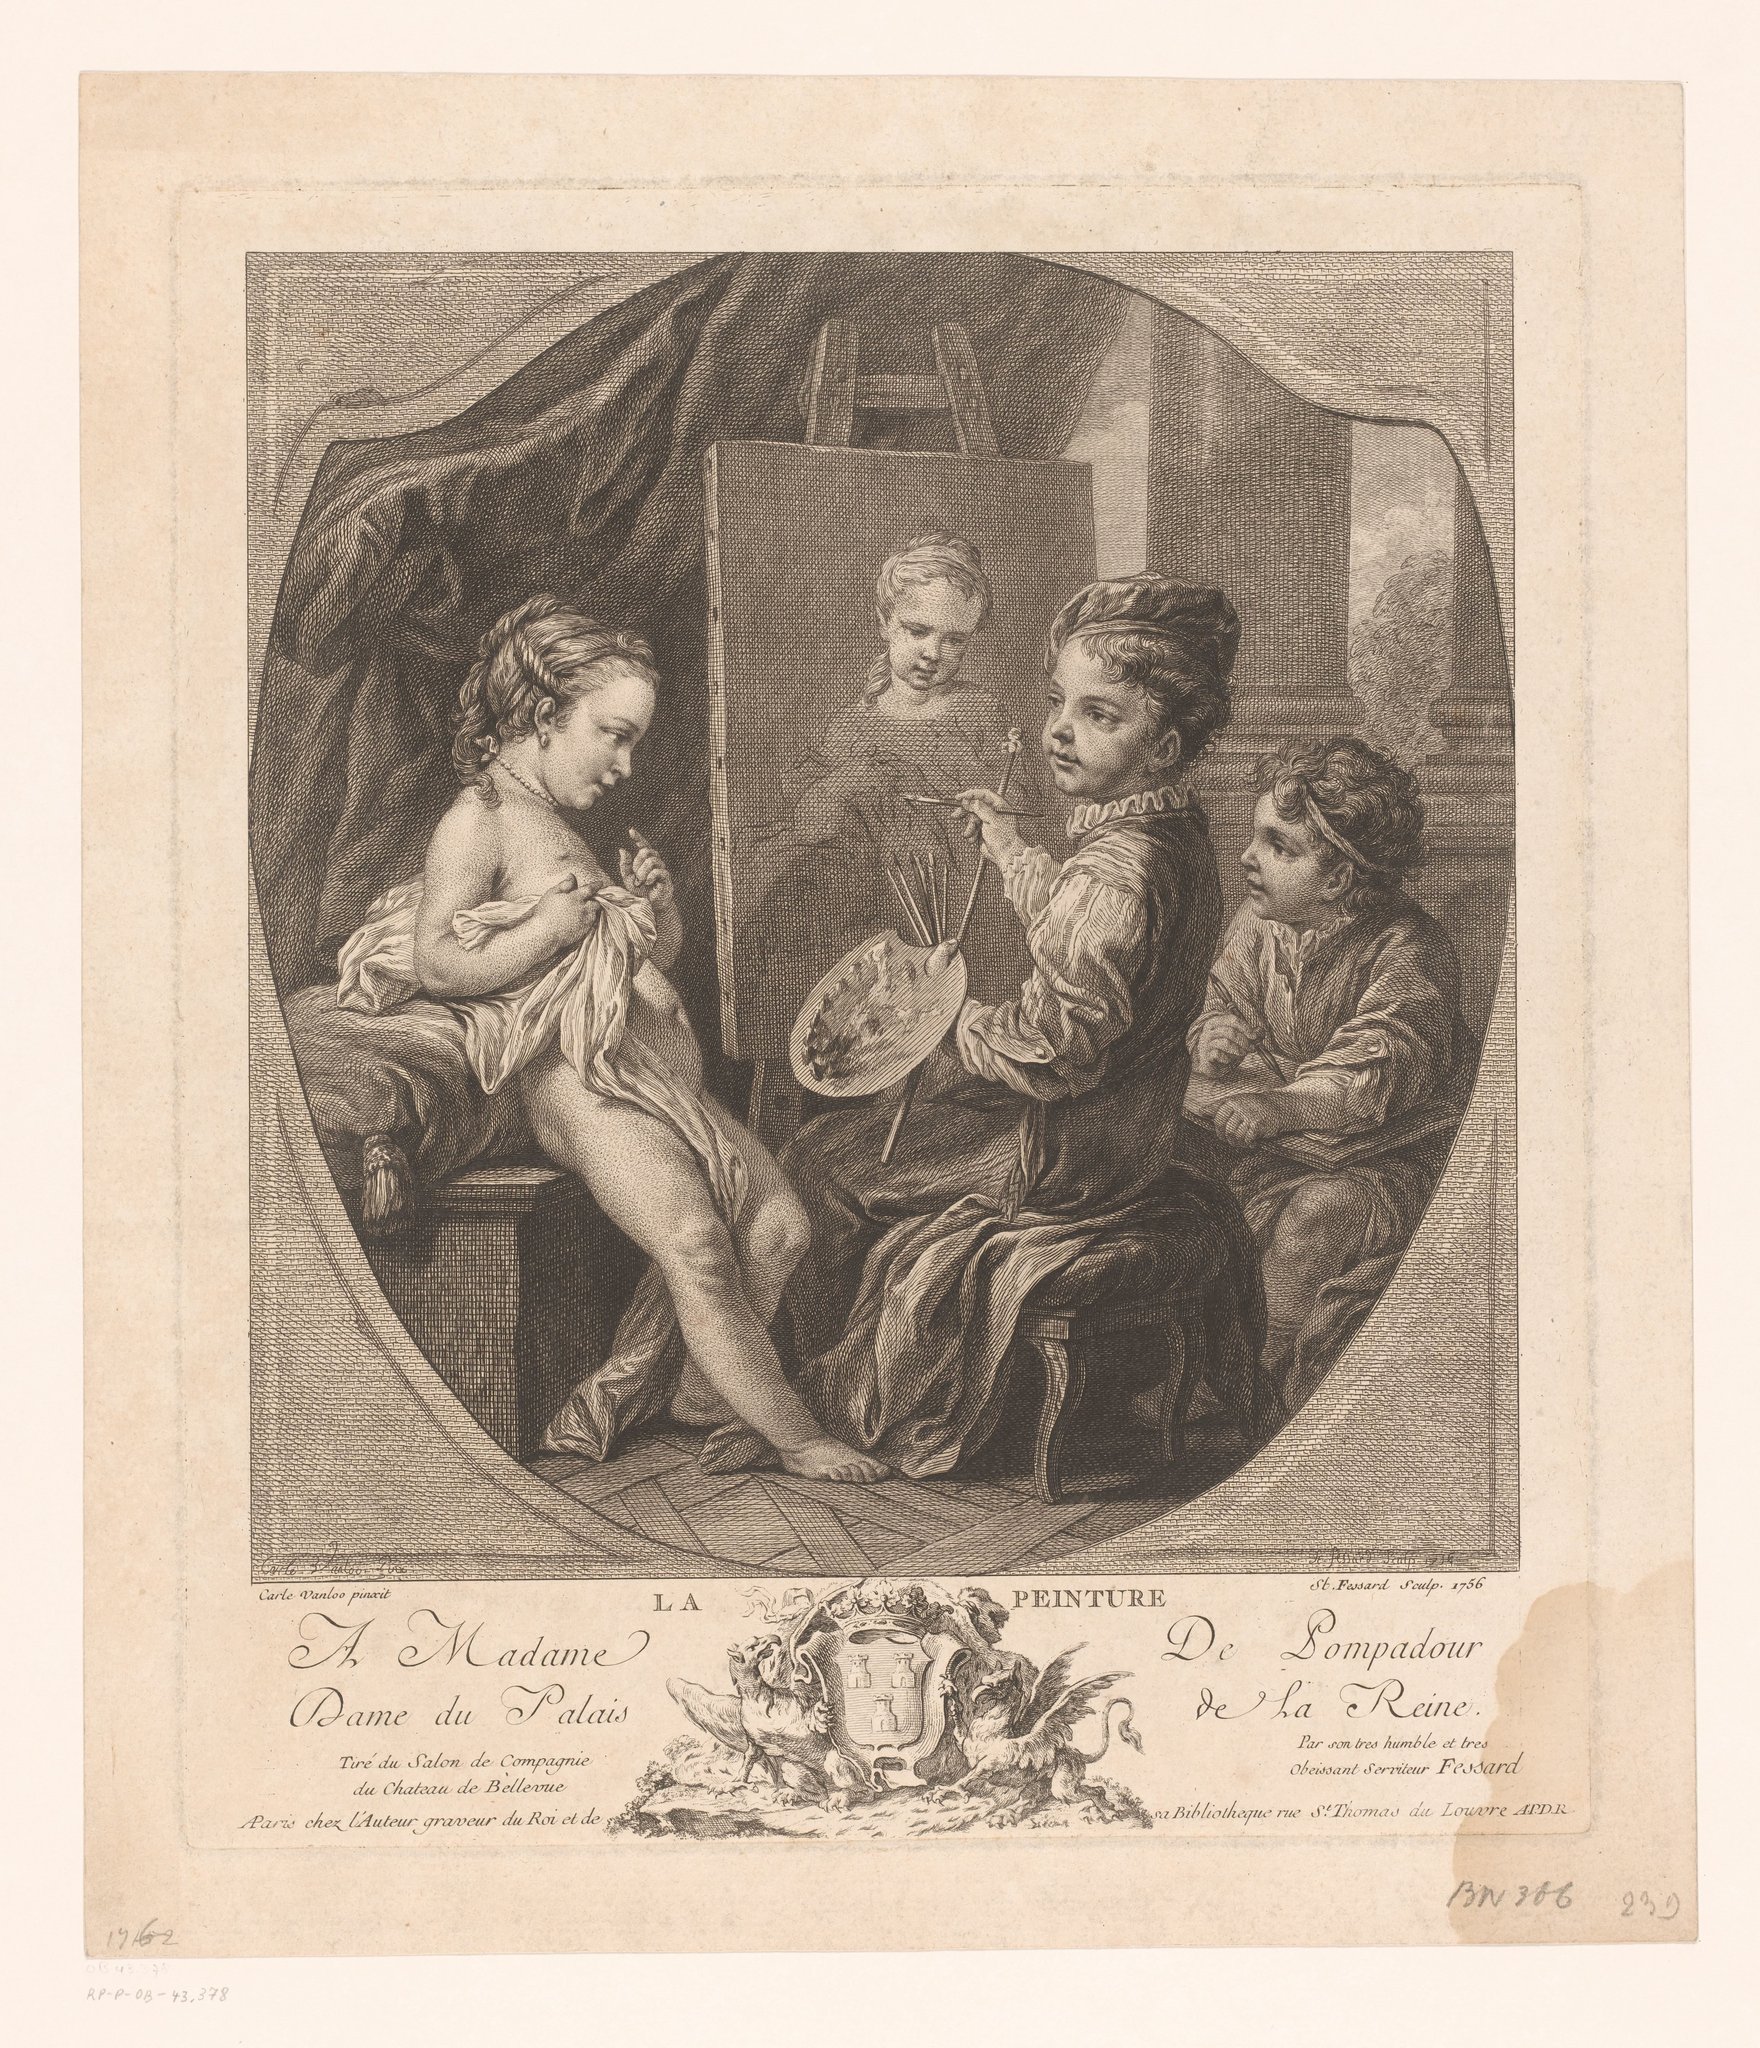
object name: print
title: La peinture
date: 1756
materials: paper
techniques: engraving, etching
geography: france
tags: children behaving like adults, painting, drawing and the graphic arts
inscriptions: collector's mark: Lugt 2228